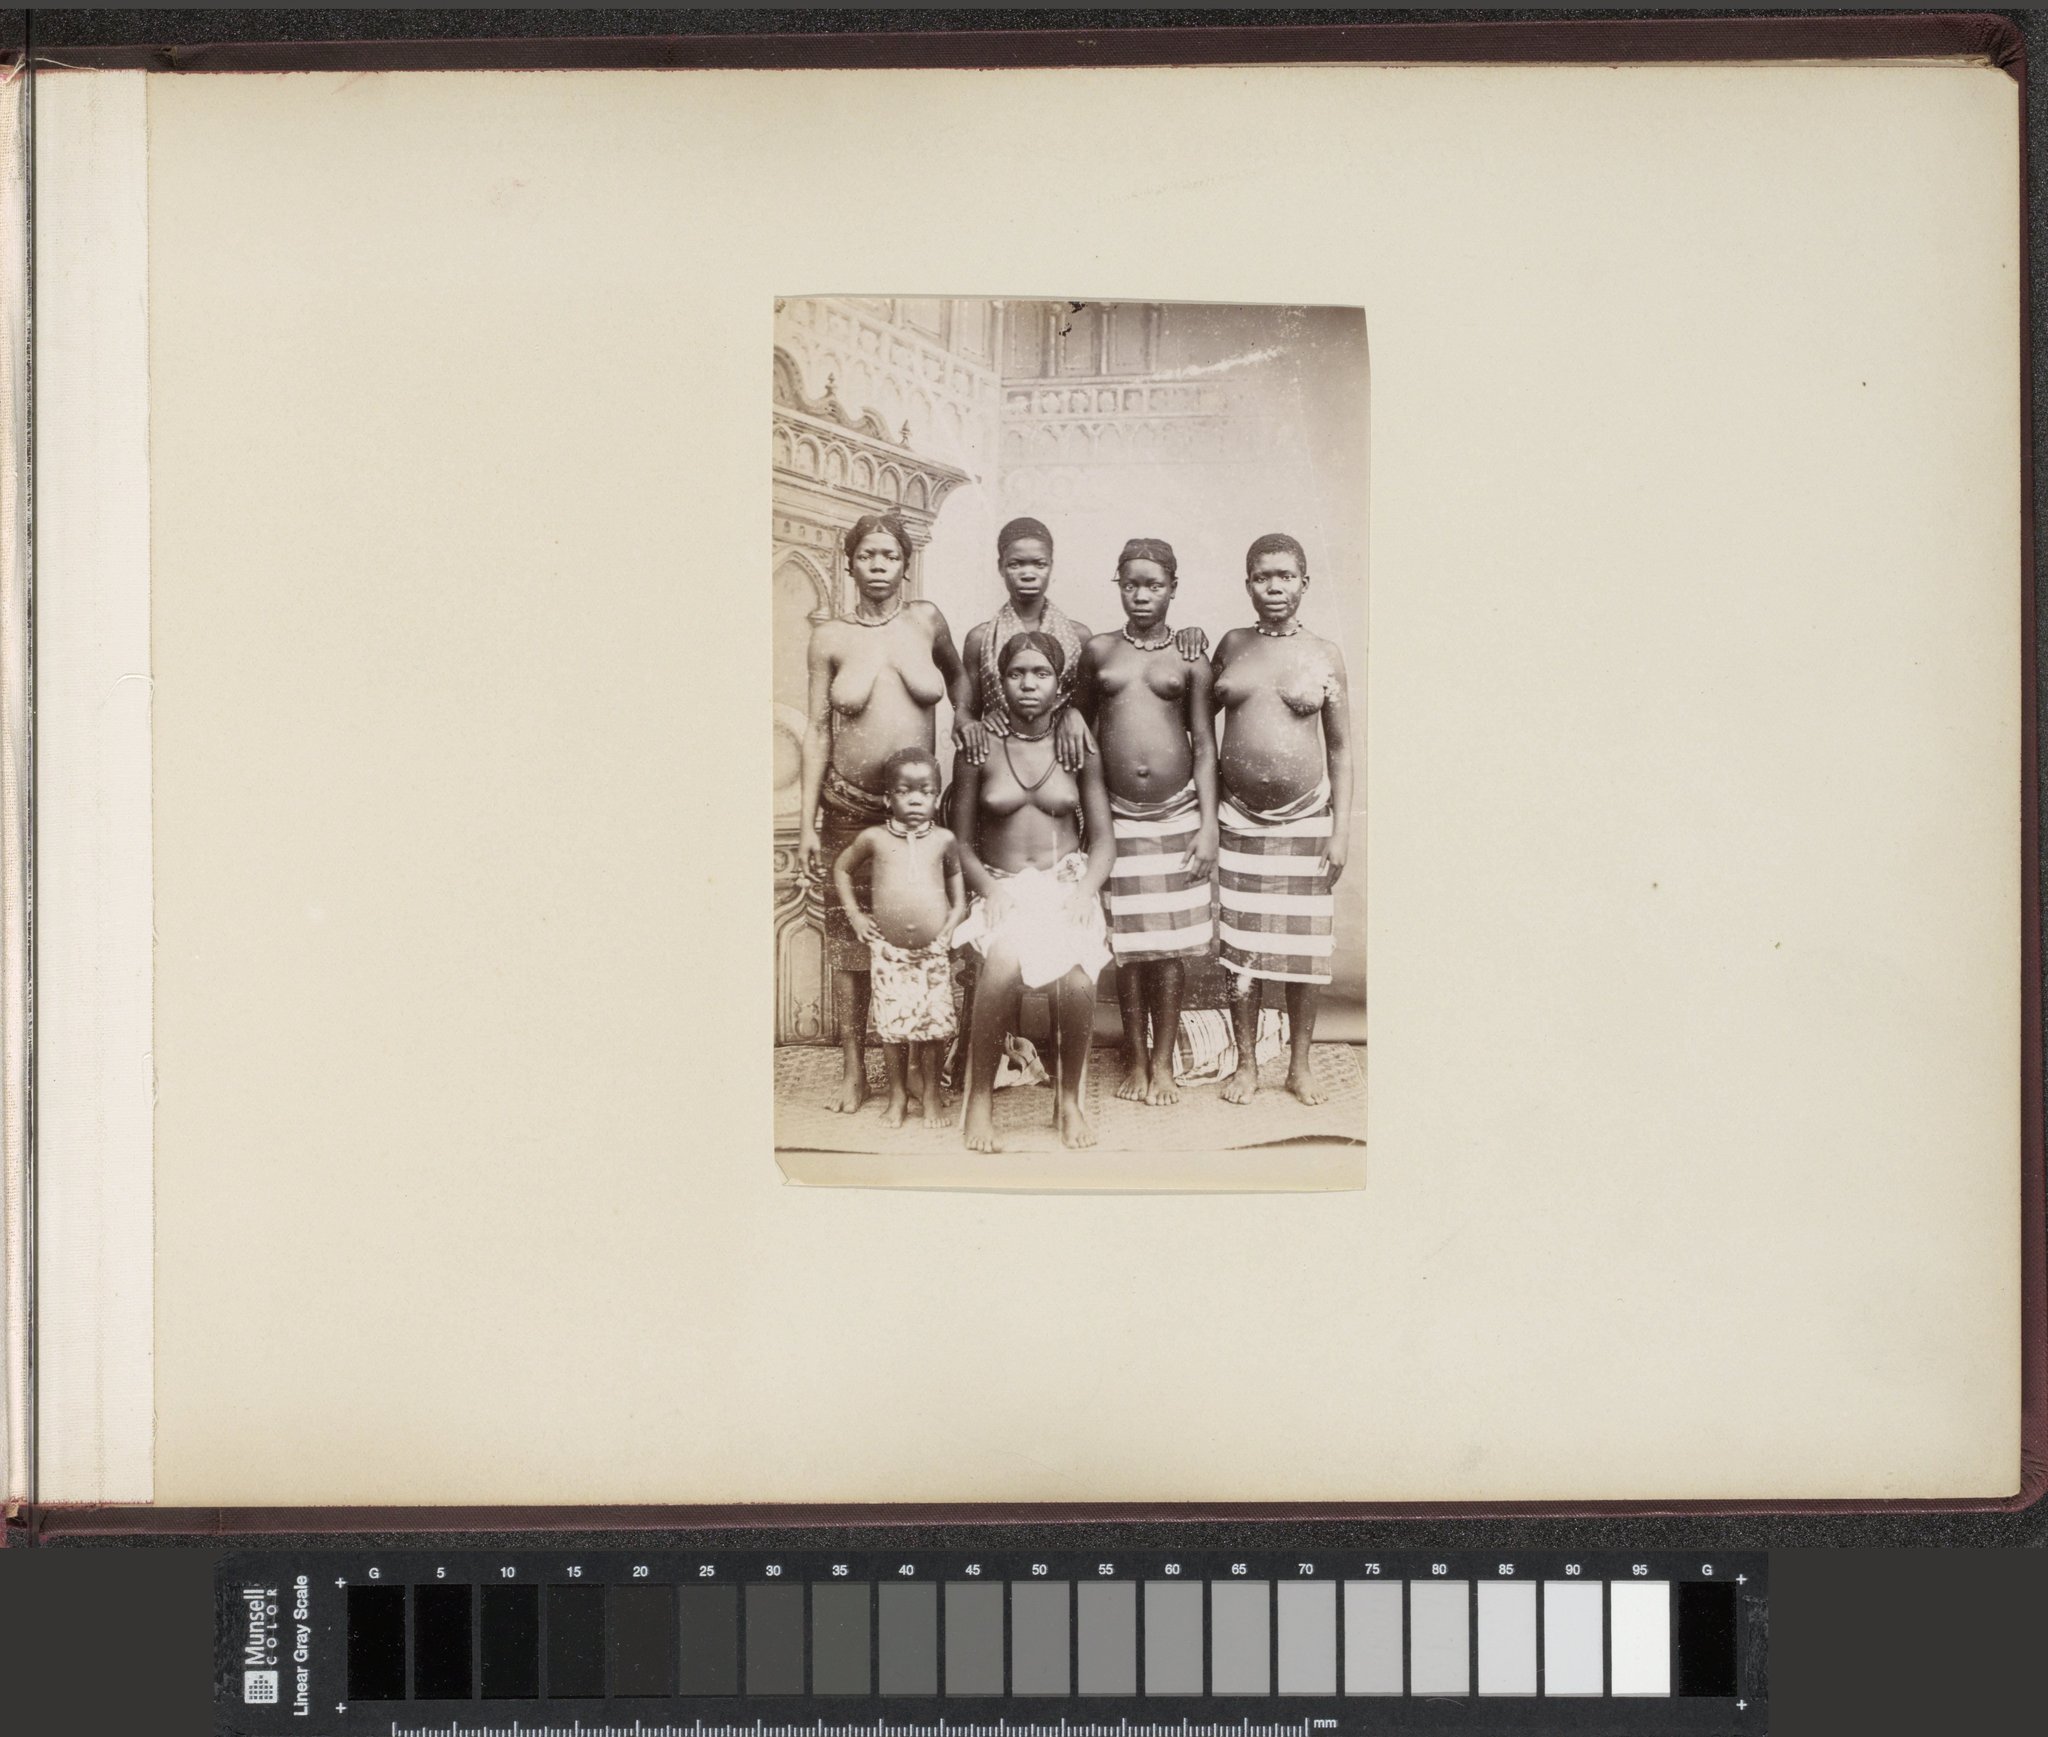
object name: photograph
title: Studioportret van vijf halfnaakte Afrikaanse vrouwen en een kind, mogelijk verwanten van King Bell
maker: Anonymous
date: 1890-1899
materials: photographic support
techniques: albumen print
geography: cameroon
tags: adult woman, studio requisites ~ photographer, child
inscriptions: inscription: ‘[...] King Bell’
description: Ndumbé Lobé Bell (1839-1897) of King Bell was koning van de Douala in Kameroen van 1858 tot 1897.